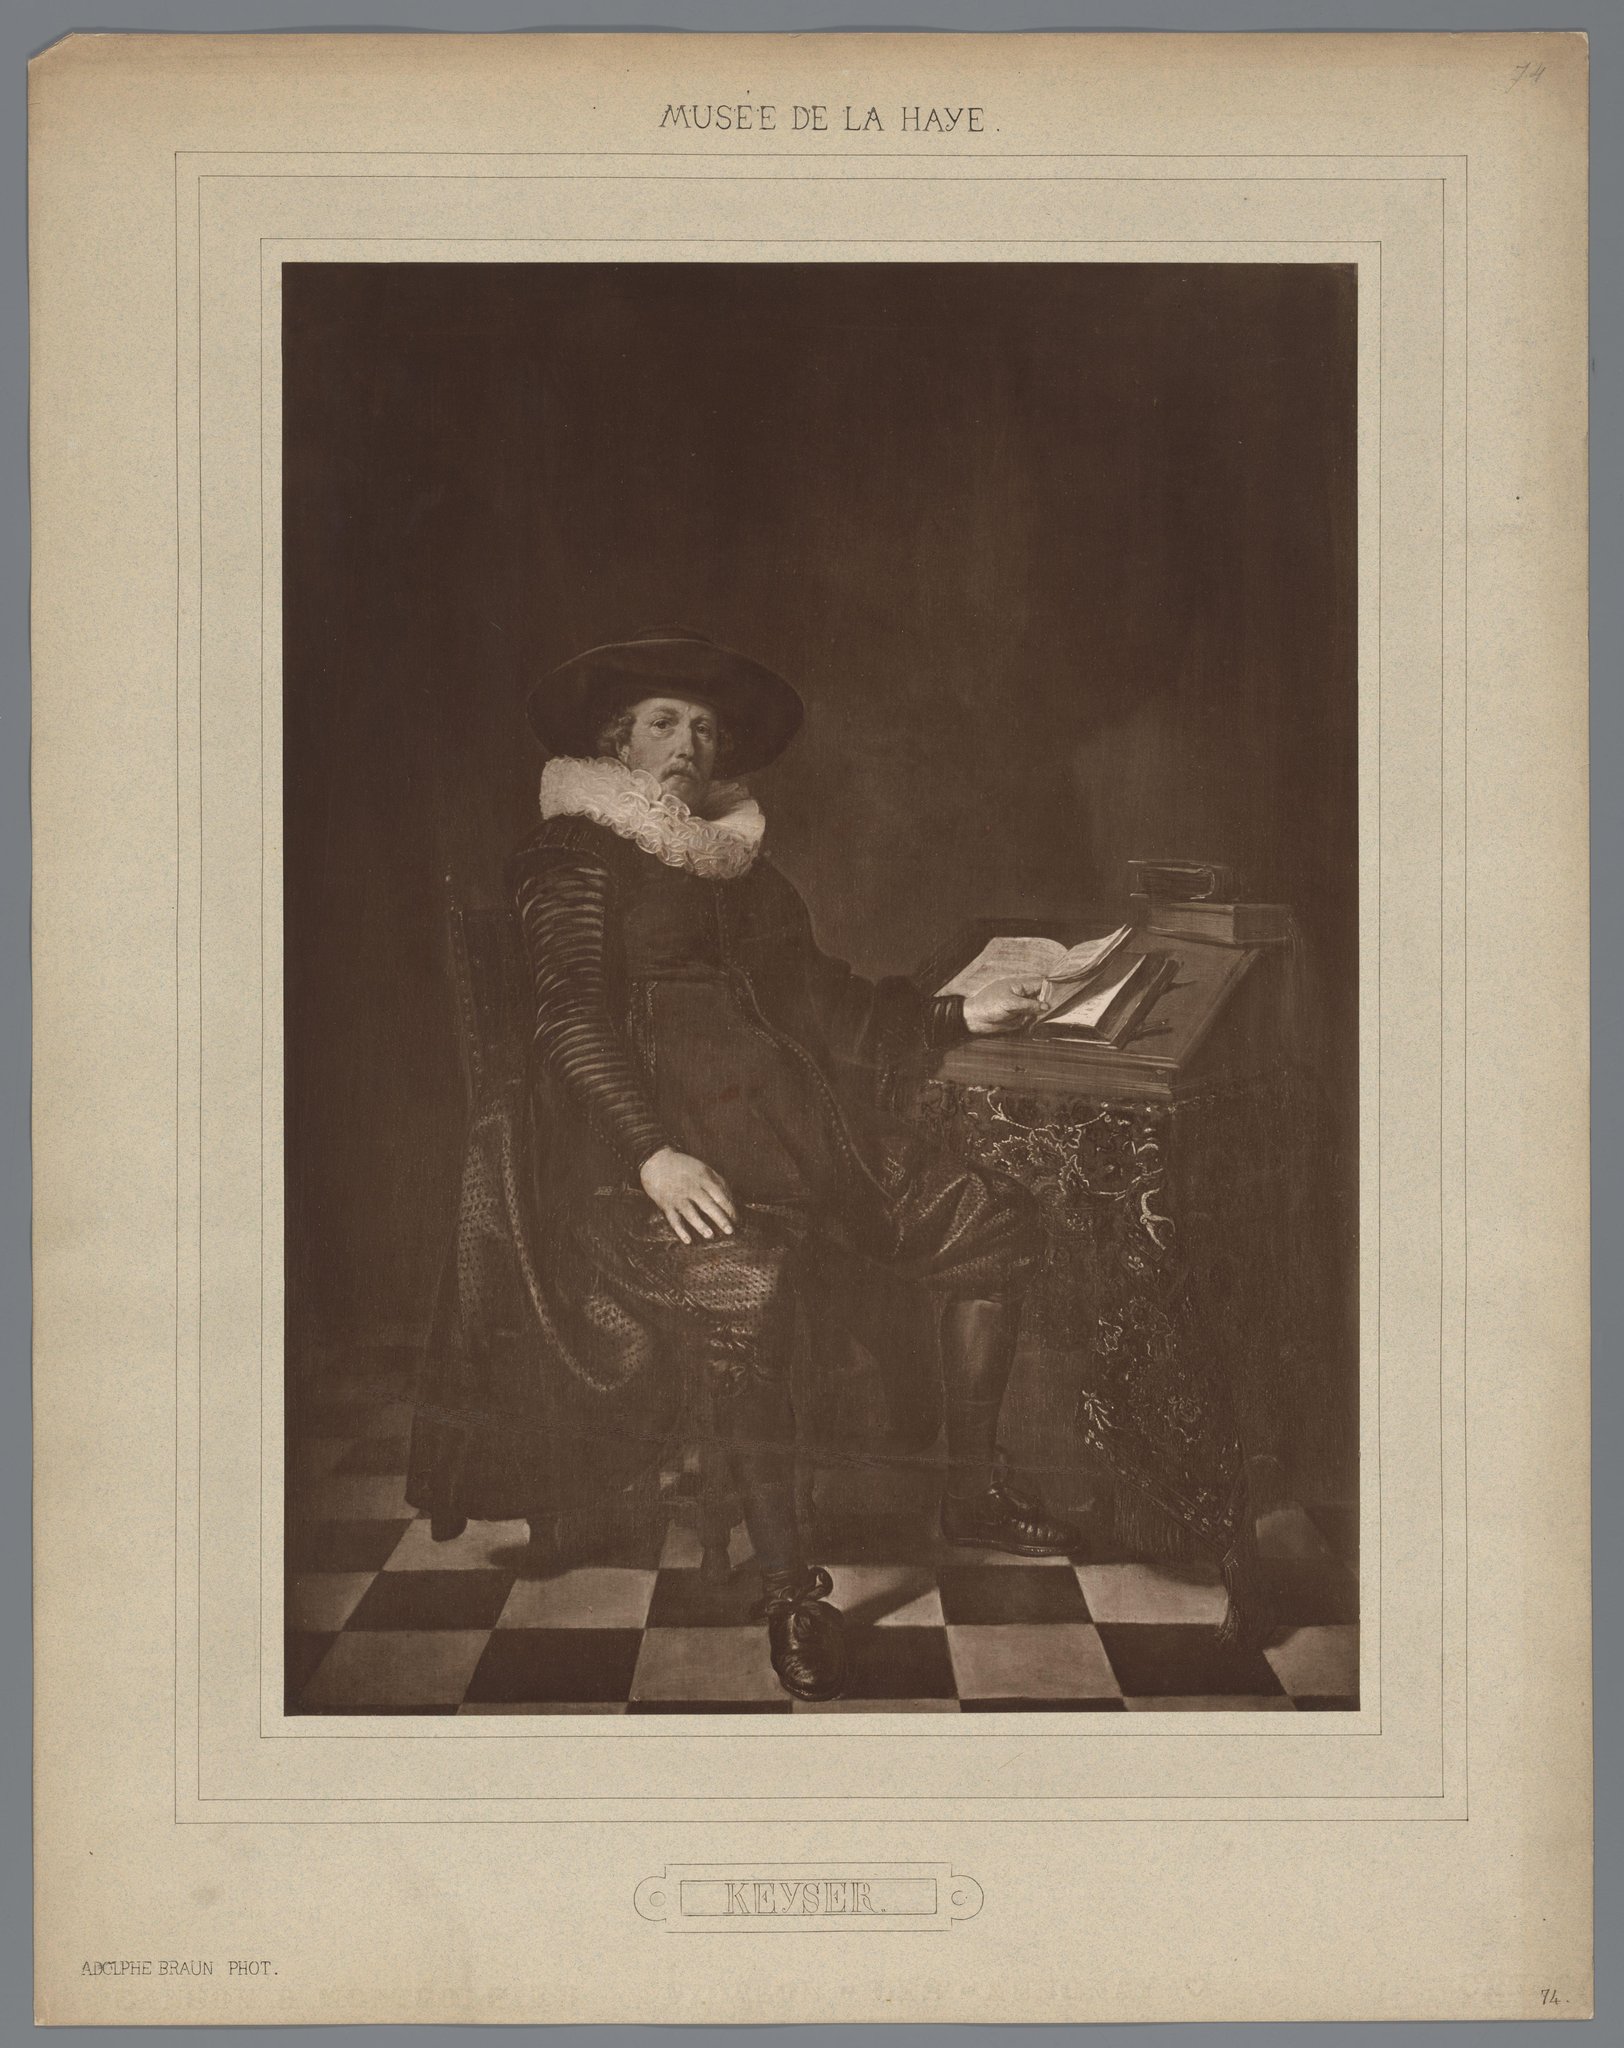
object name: photograph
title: Fotoreproductie van een schilderij van Thomas de Keyser, 'Portret van een geleerde' (coll. Mauritshuis)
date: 1880-1900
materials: cardboard, paper, photographic support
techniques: carbon print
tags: mauritshuis